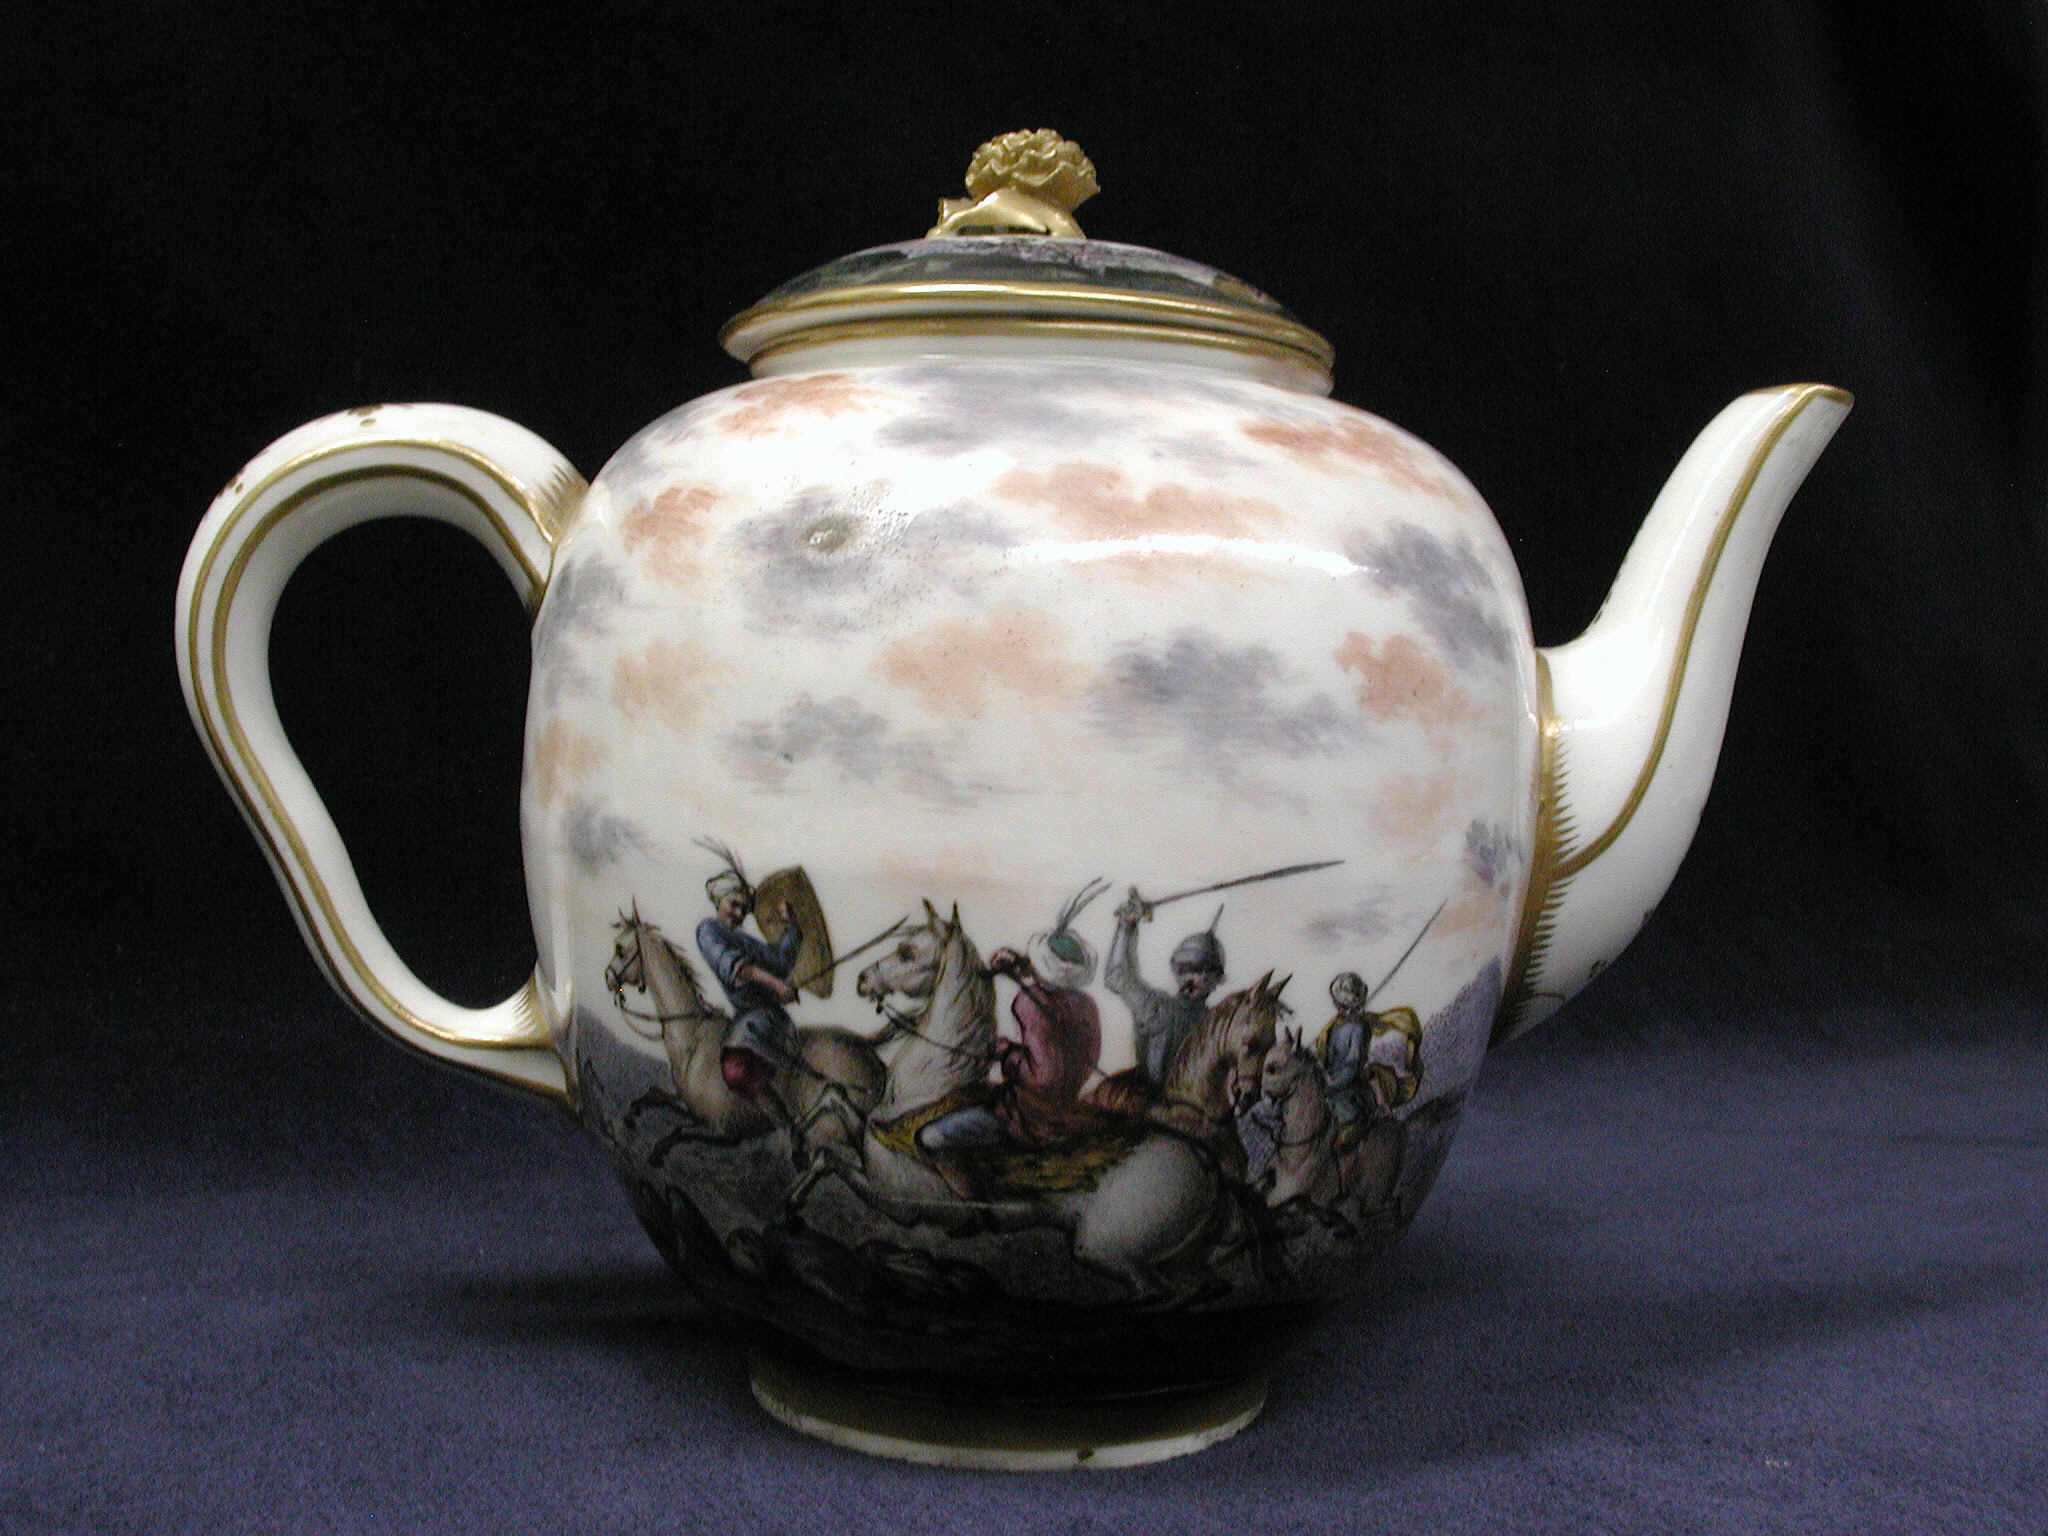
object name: teapot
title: Teapot (part of a set)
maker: capodimonte porcelain manufactory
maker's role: manufactory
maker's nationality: italian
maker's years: 1740-1759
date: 1743-1759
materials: soft paste porcelain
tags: battles,men,horses